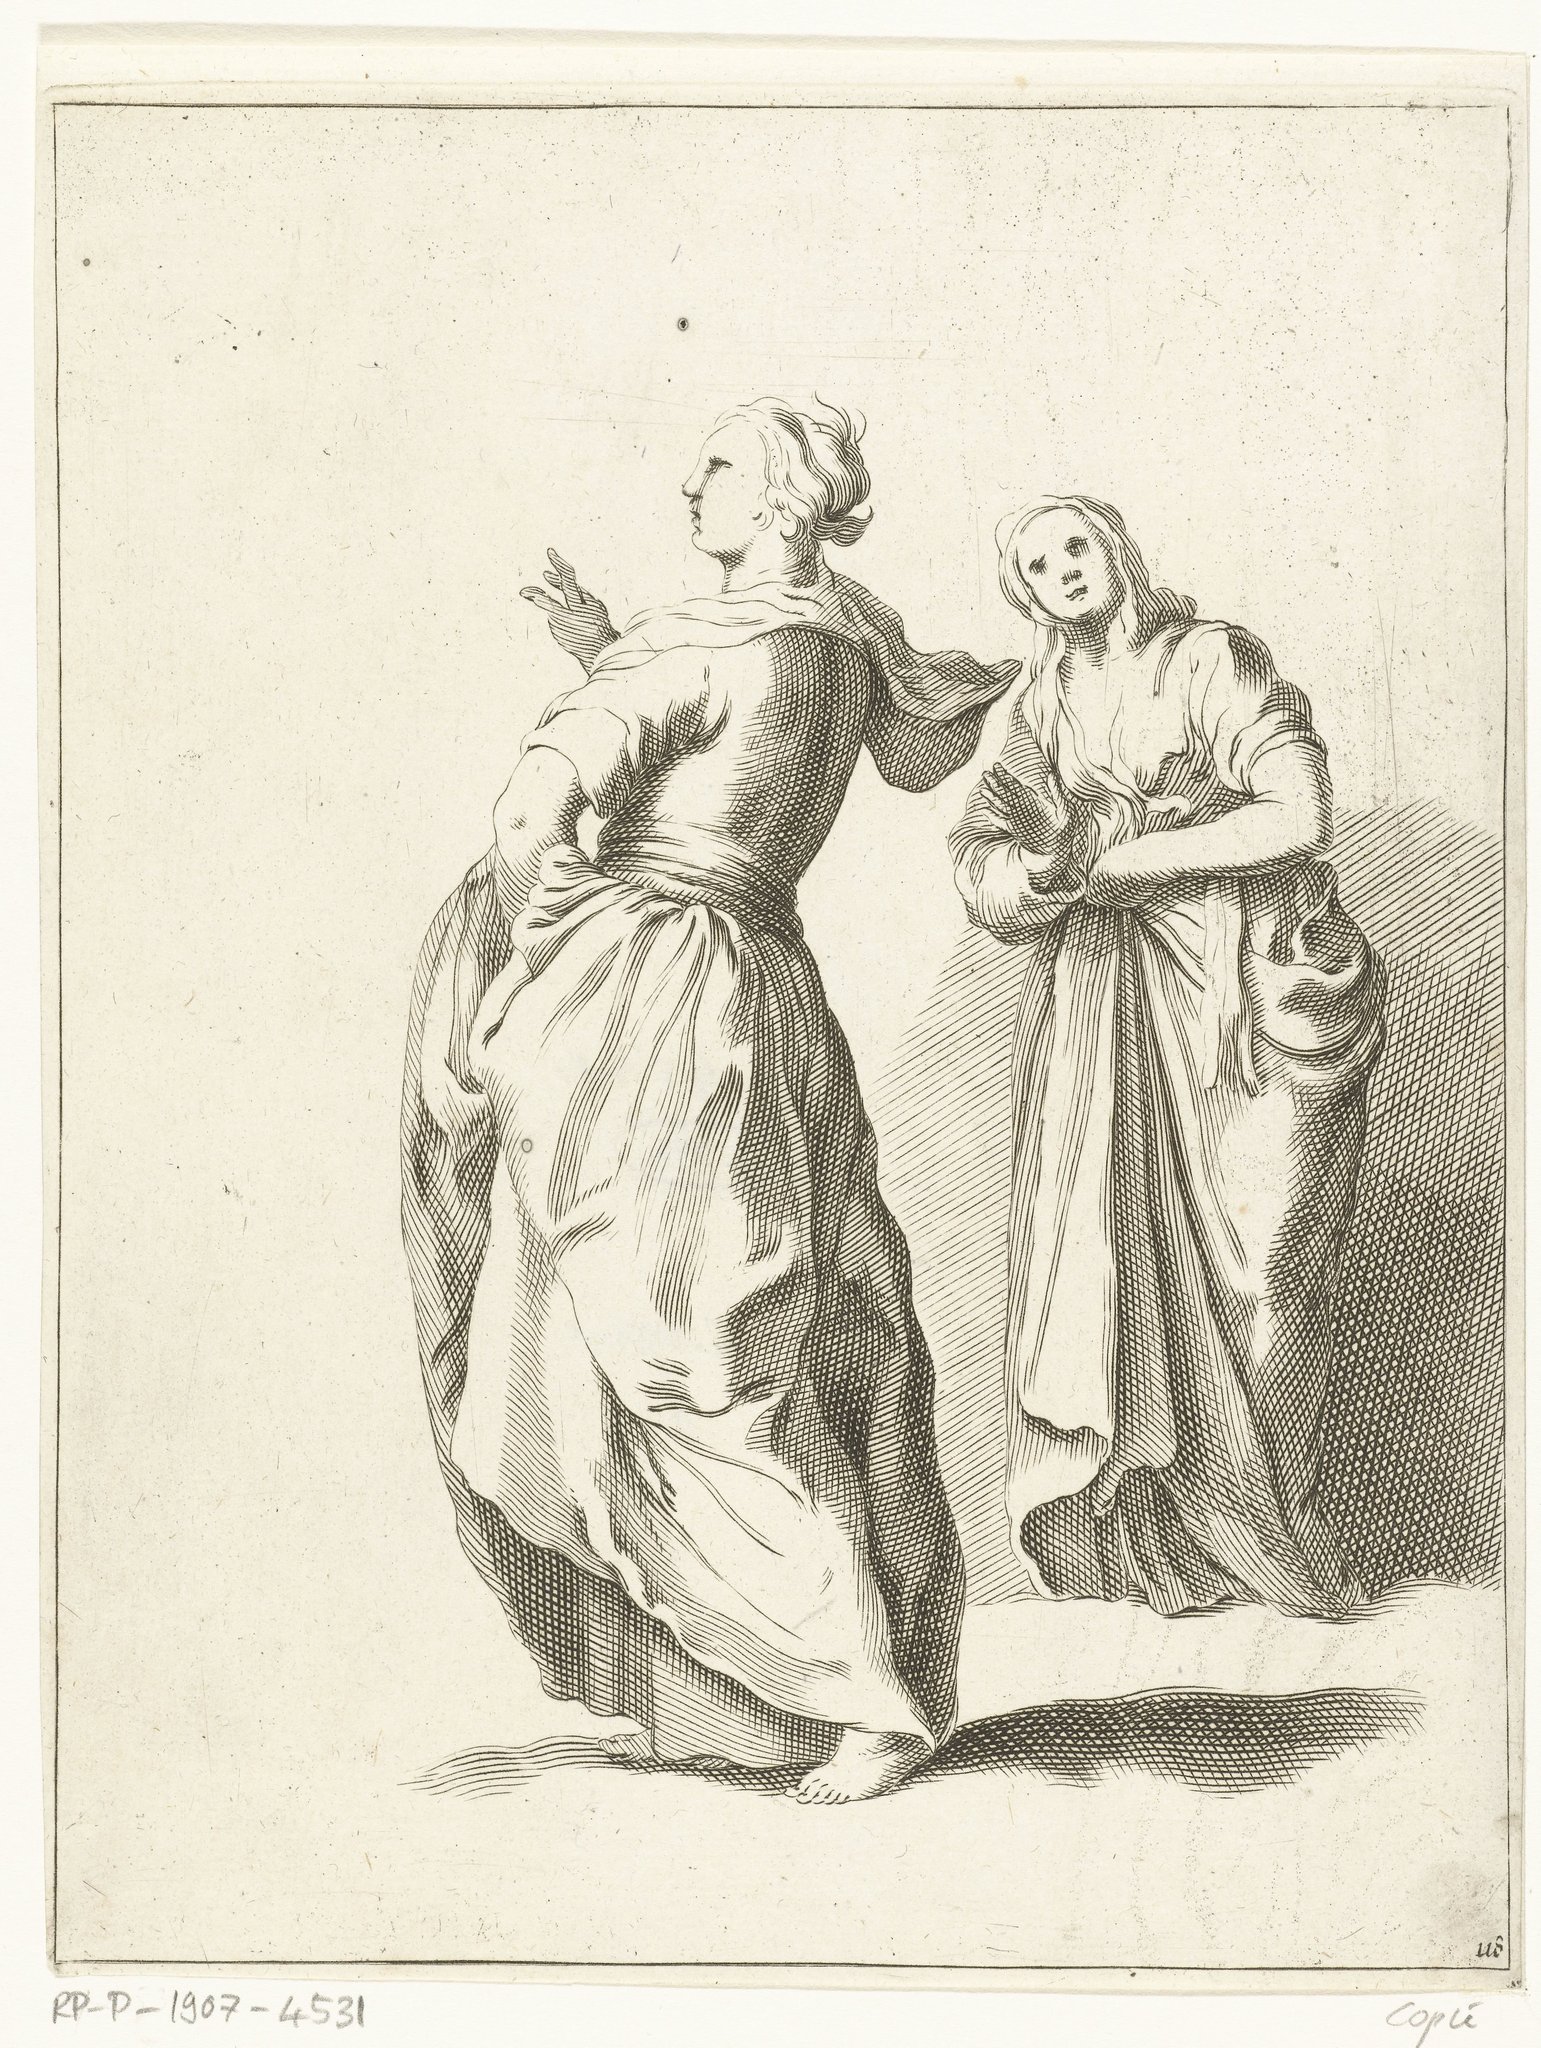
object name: print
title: Twee vrouwen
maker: Anonymous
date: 1679-1750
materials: paper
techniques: engraving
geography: netherlands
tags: adult woman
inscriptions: collector's mark: Lugt 2228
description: Studie van twee vrouwen: vooraanzicht en zijwaarts. Kopie naar een voorstelling uit het tekenboek van Abraham Bloemaert, in de editie van Nicolaas Visscher.